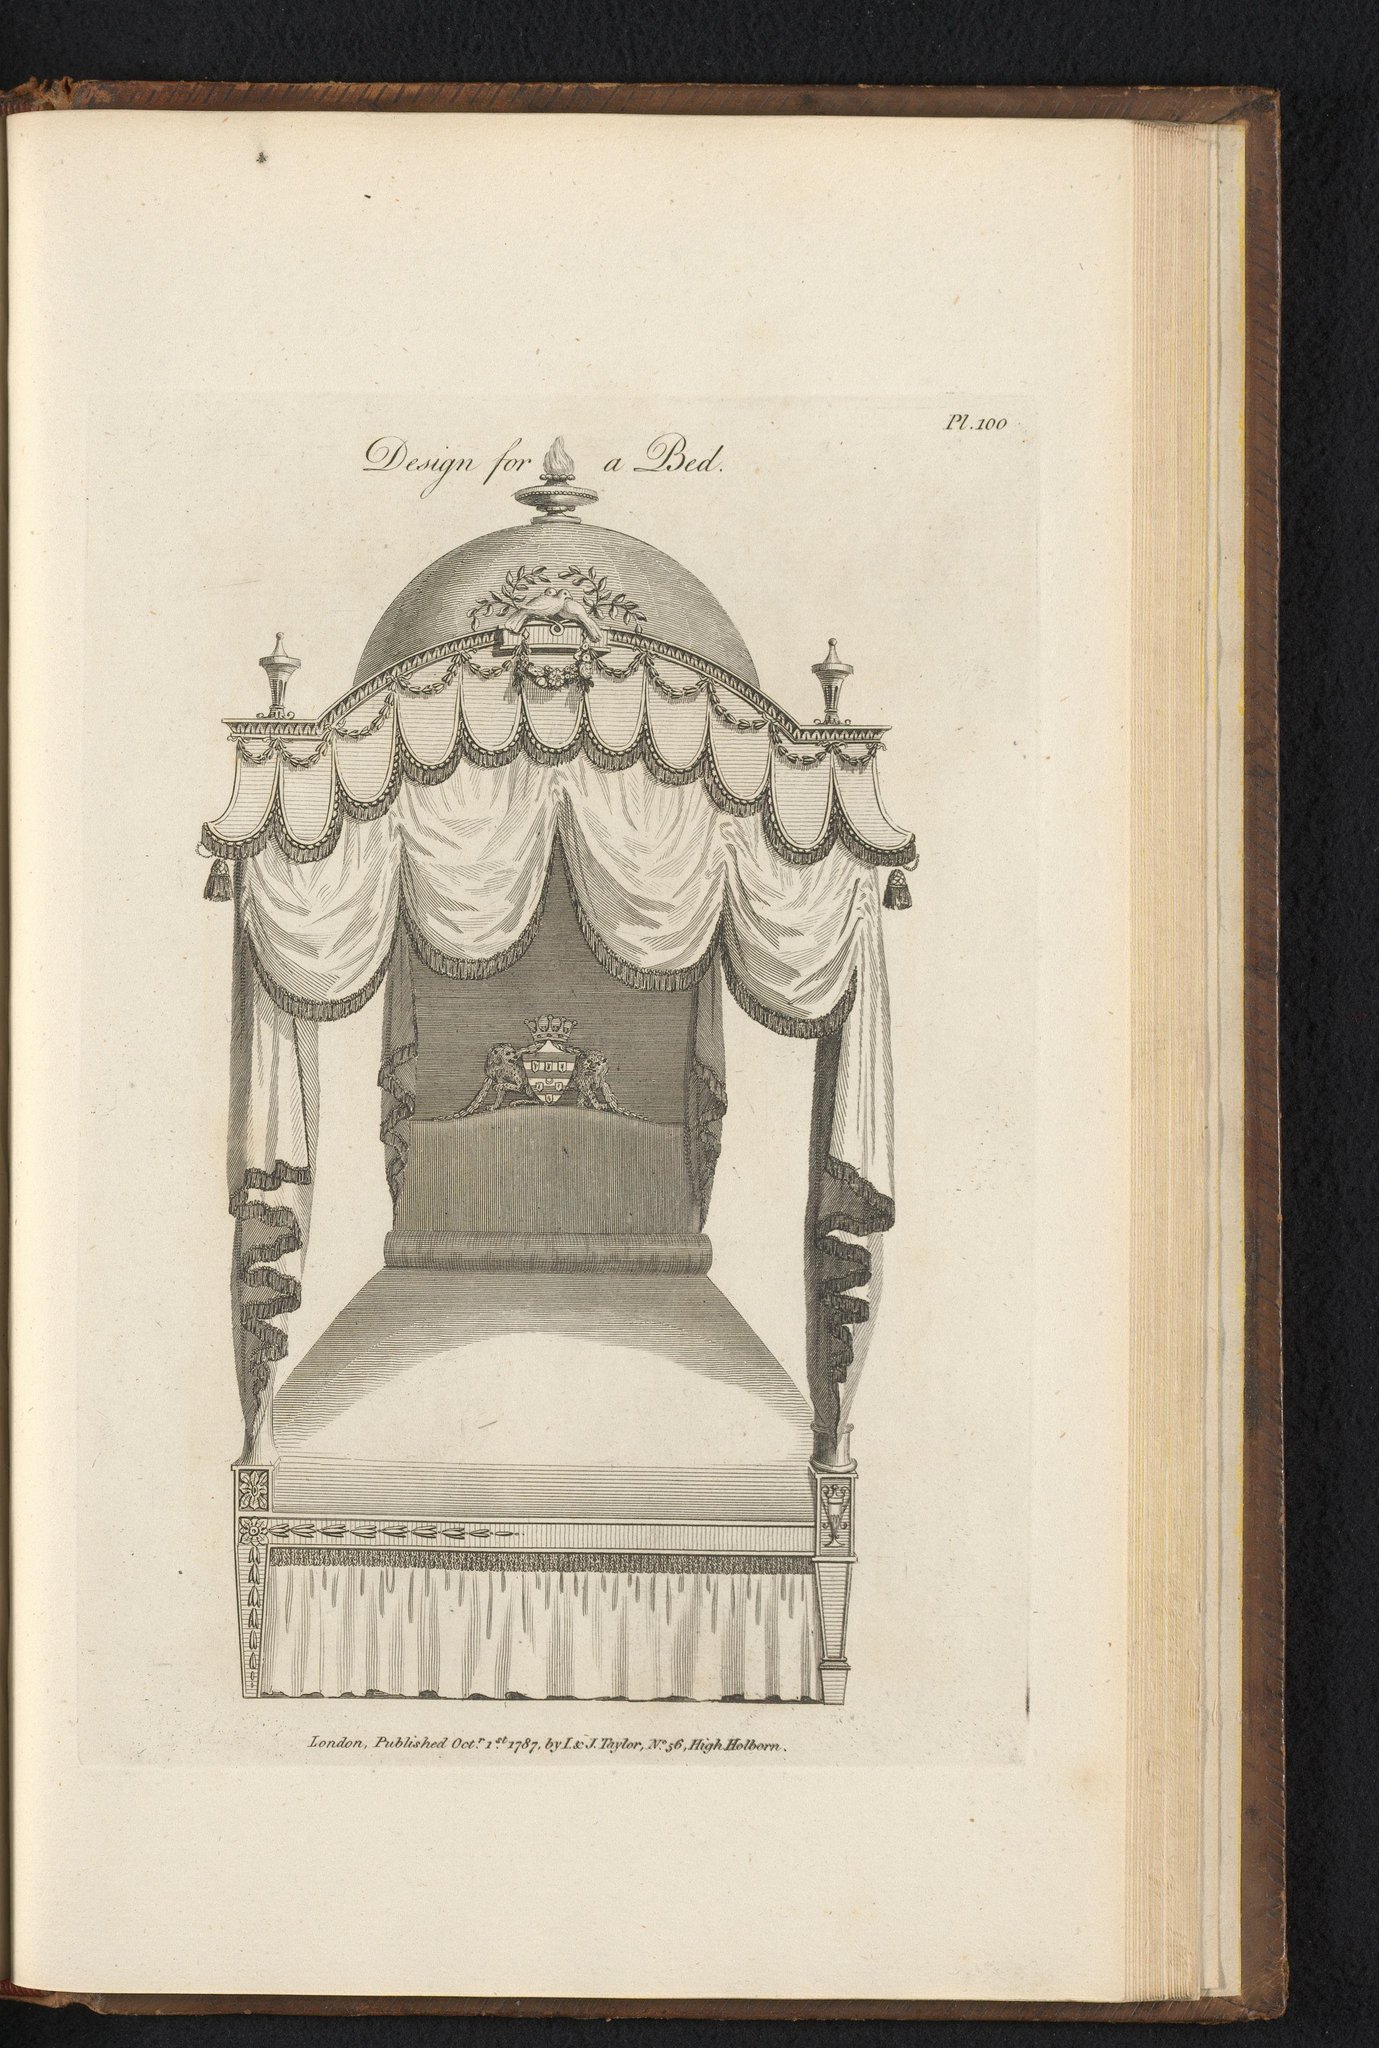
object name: print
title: Design for a Bed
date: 1787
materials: paper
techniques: engraving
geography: holborn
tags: bed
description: Genummerd: Pl. 100. Prent maakt deel uit van een boek.